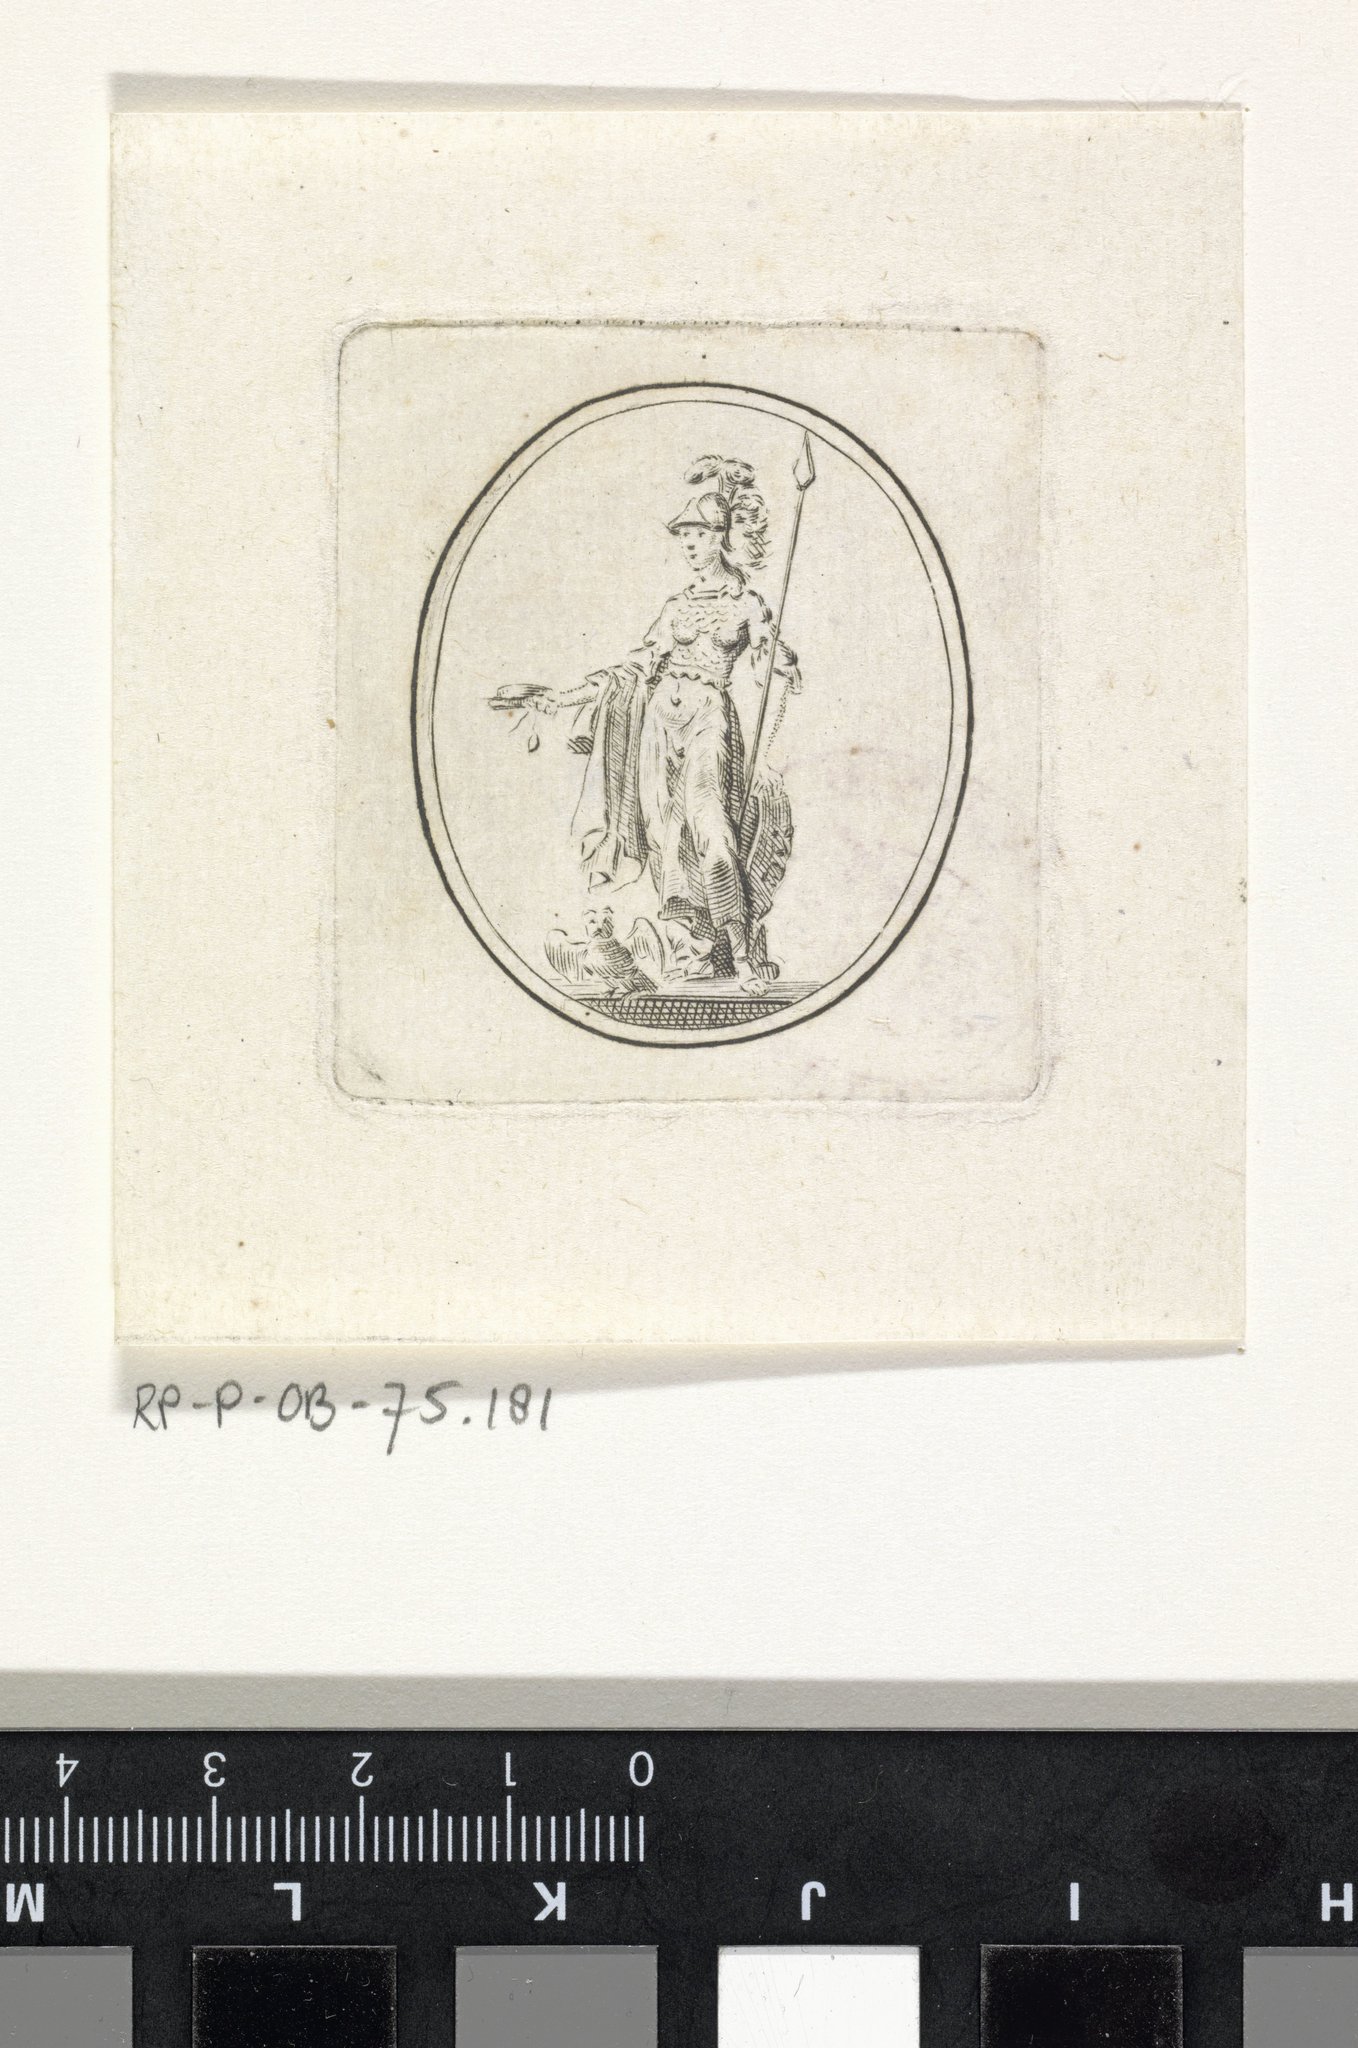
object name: print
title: Minerva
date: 1700-1800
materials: paper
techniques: engraving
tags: (story of) minerva (pallas, athena)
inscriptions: collector's mark: Lugt 240